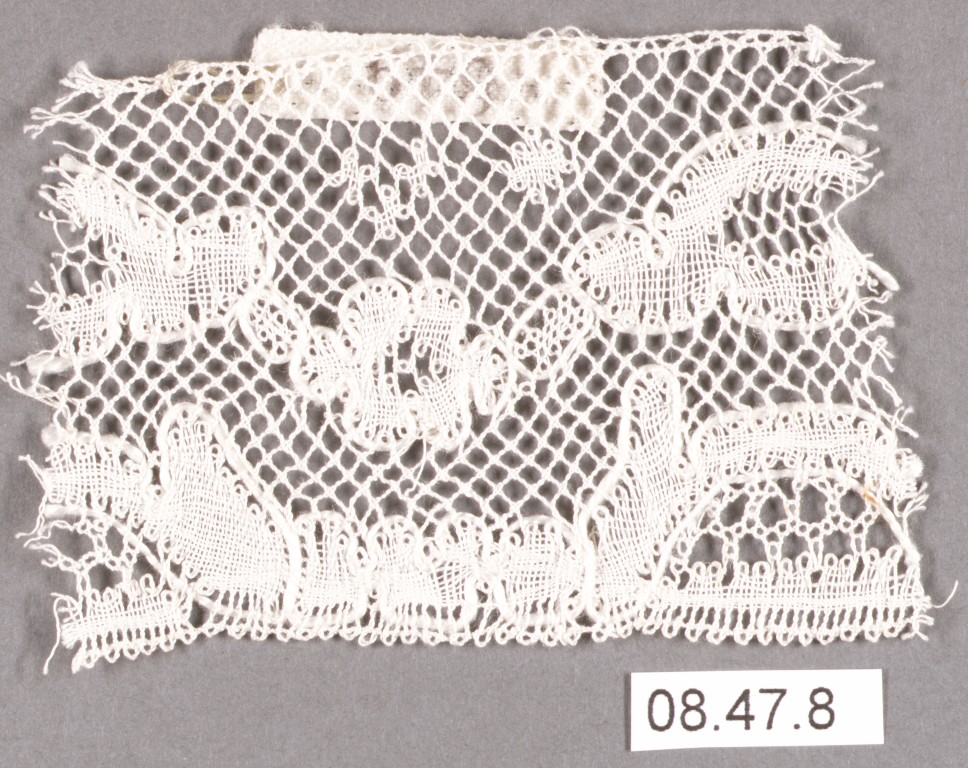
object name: fragment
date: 1801-1900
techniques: lace